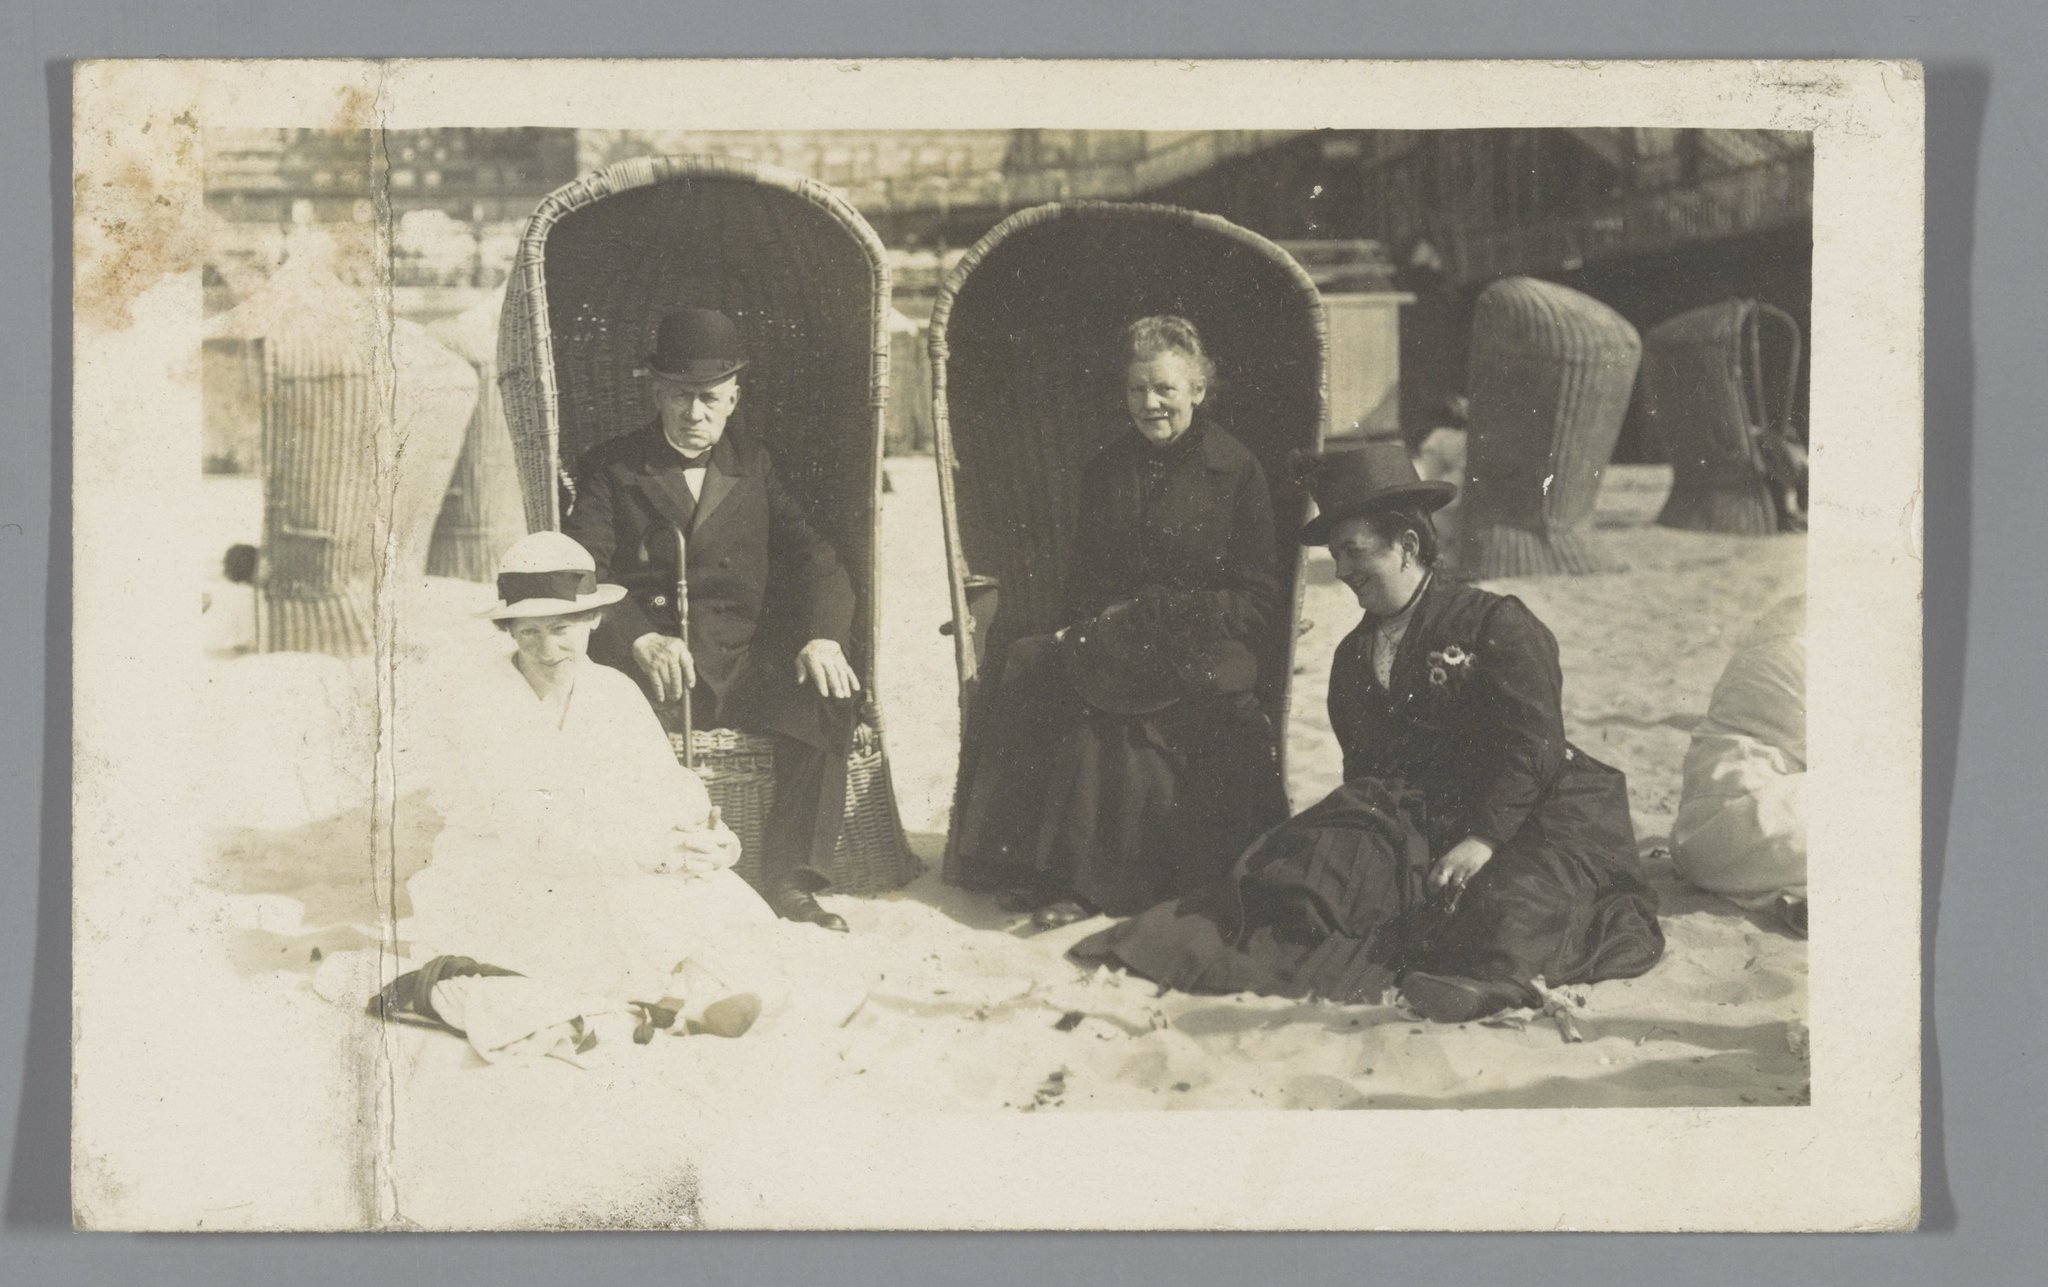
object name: photograph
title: Portret van een onbekende familie op het strand van Scheveningen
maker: pieter van der neut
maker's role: fotograaf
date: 1910-1935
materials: photographic support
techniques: gelatin silver print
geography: scheveningen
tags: beach (as place of recreation), family relationships (first, second, third and fourth degree), generations, chair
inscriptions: name: ‘P. v.d. Neut Photograaf Prins Willemstraat 6 Scheveningen’